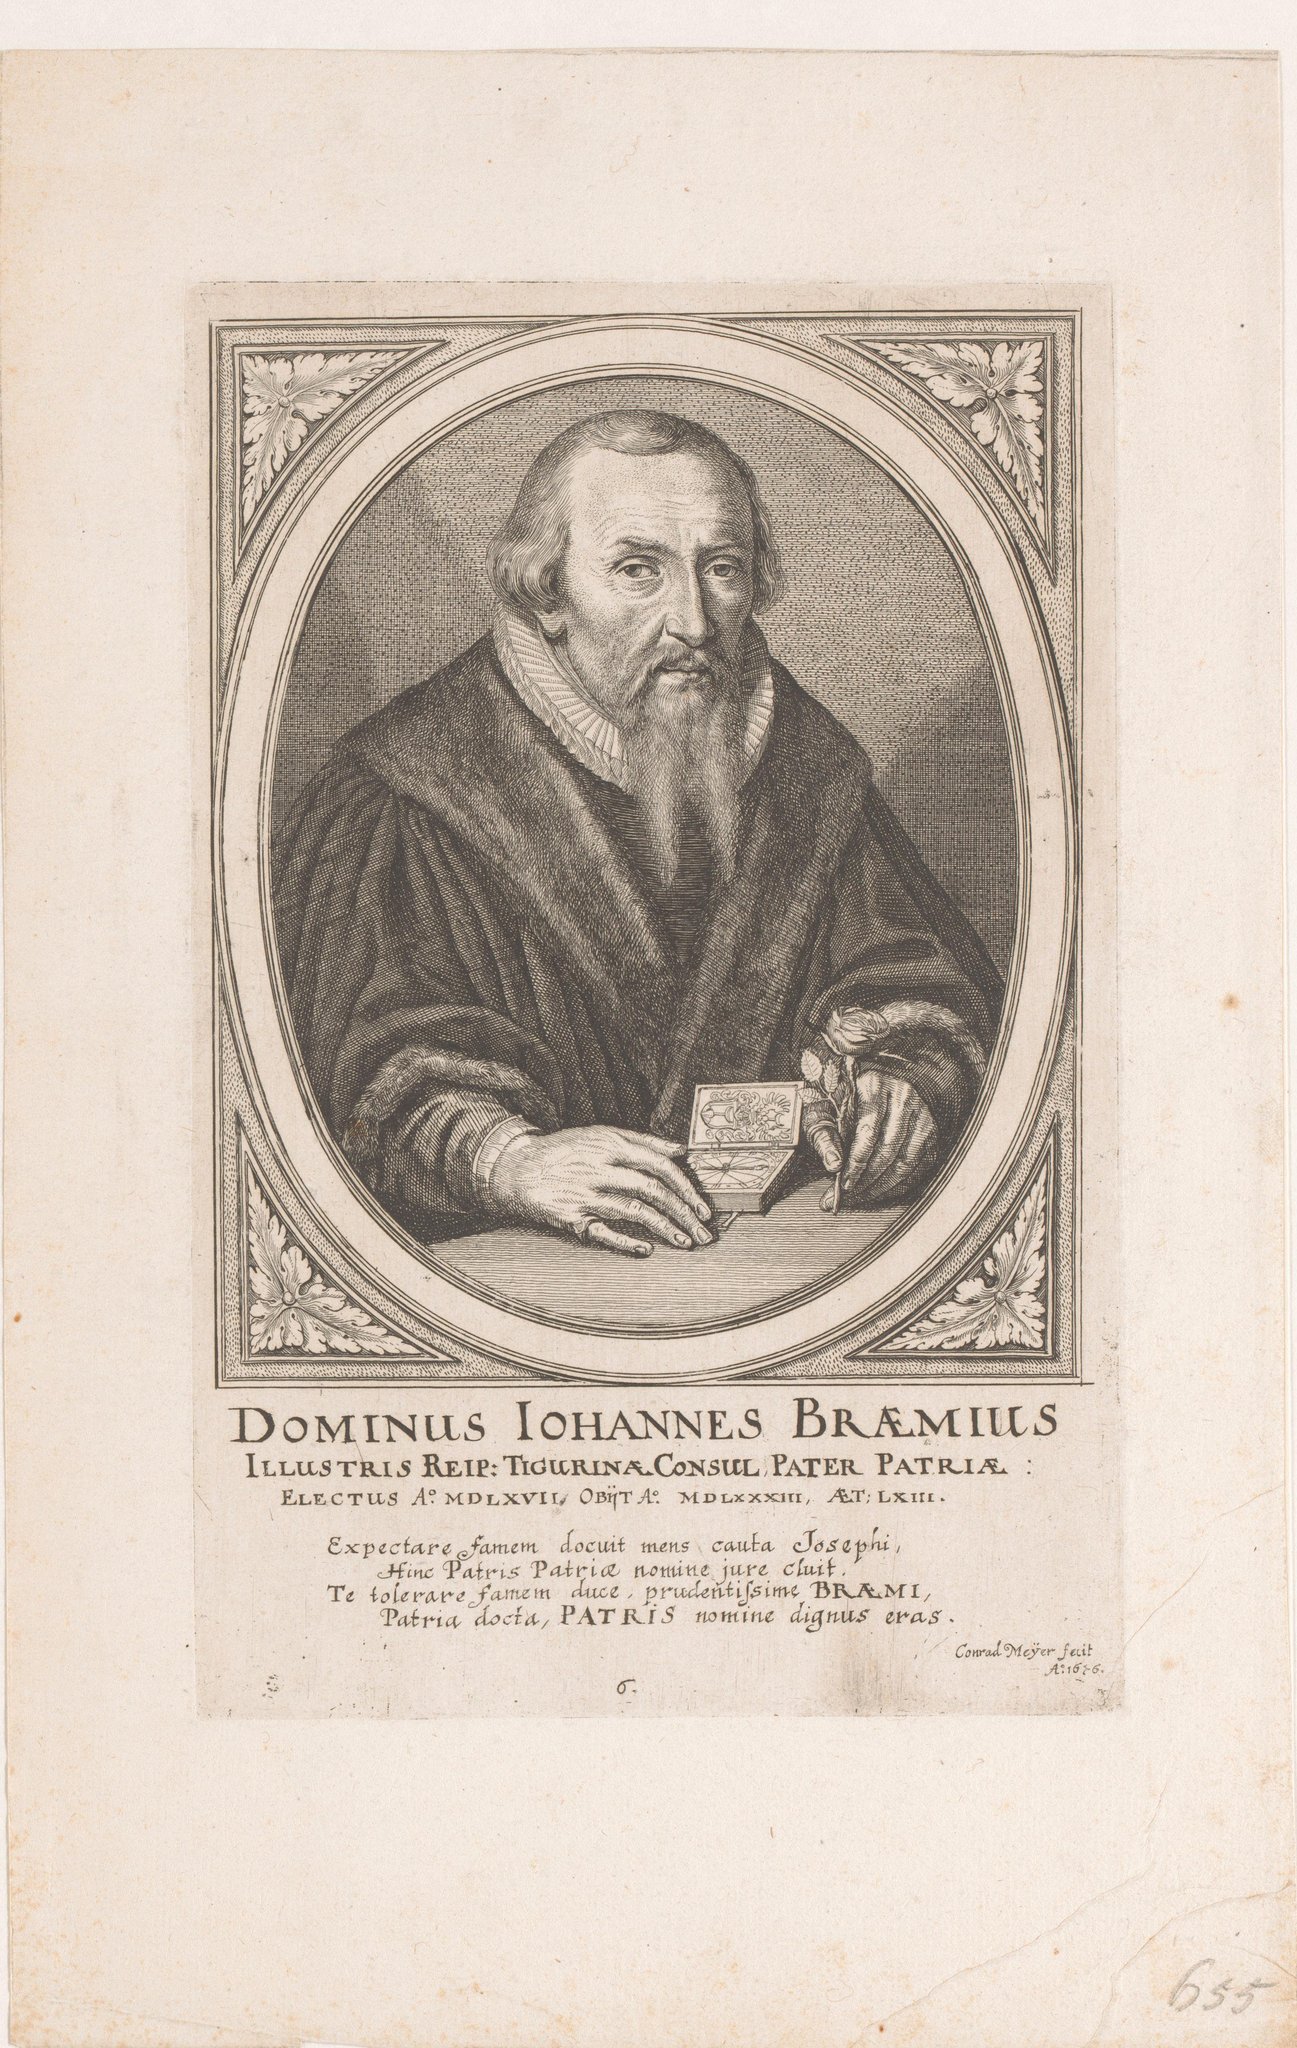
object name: print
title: Portretten van burgemeesters van Zürich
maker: conrad meyer (i)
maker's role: painter, print maker, publisher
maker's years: 1618-1689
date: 1676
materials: paper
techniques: engraving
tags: waiting, watching, historical persons, flowers: rose, armorial bearing, heraldry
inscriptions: collector's mark: Lugt 2228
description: Onderdeel van een serie van 67(?) portretten van burgemeesters van Zürich. Zie Hollstein German 110, 1-26.